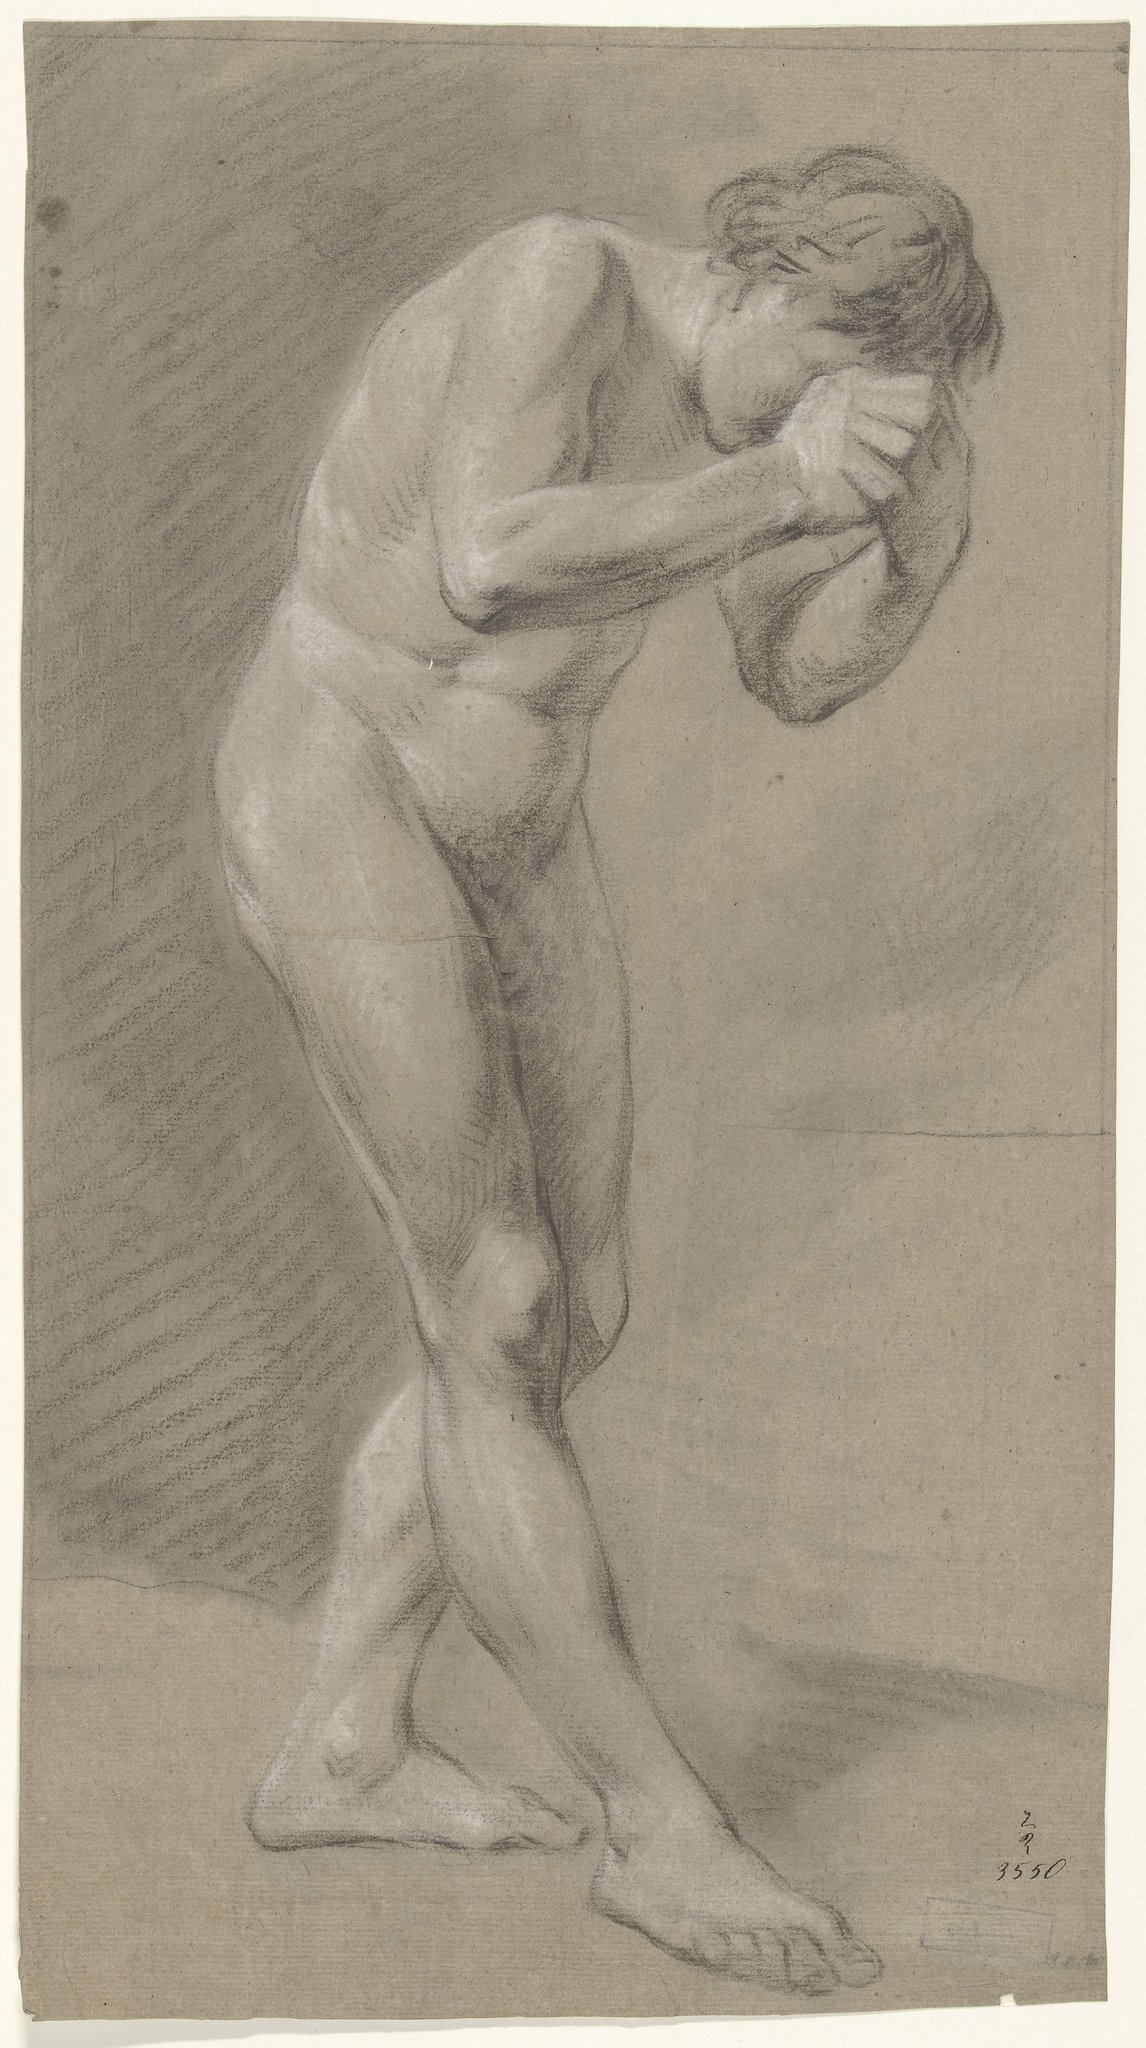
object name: drawing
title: Staand mannelijk naakt, naar rechts voorover gebogen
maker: Anonymous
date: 1770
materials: chalk, paper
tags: standing figure